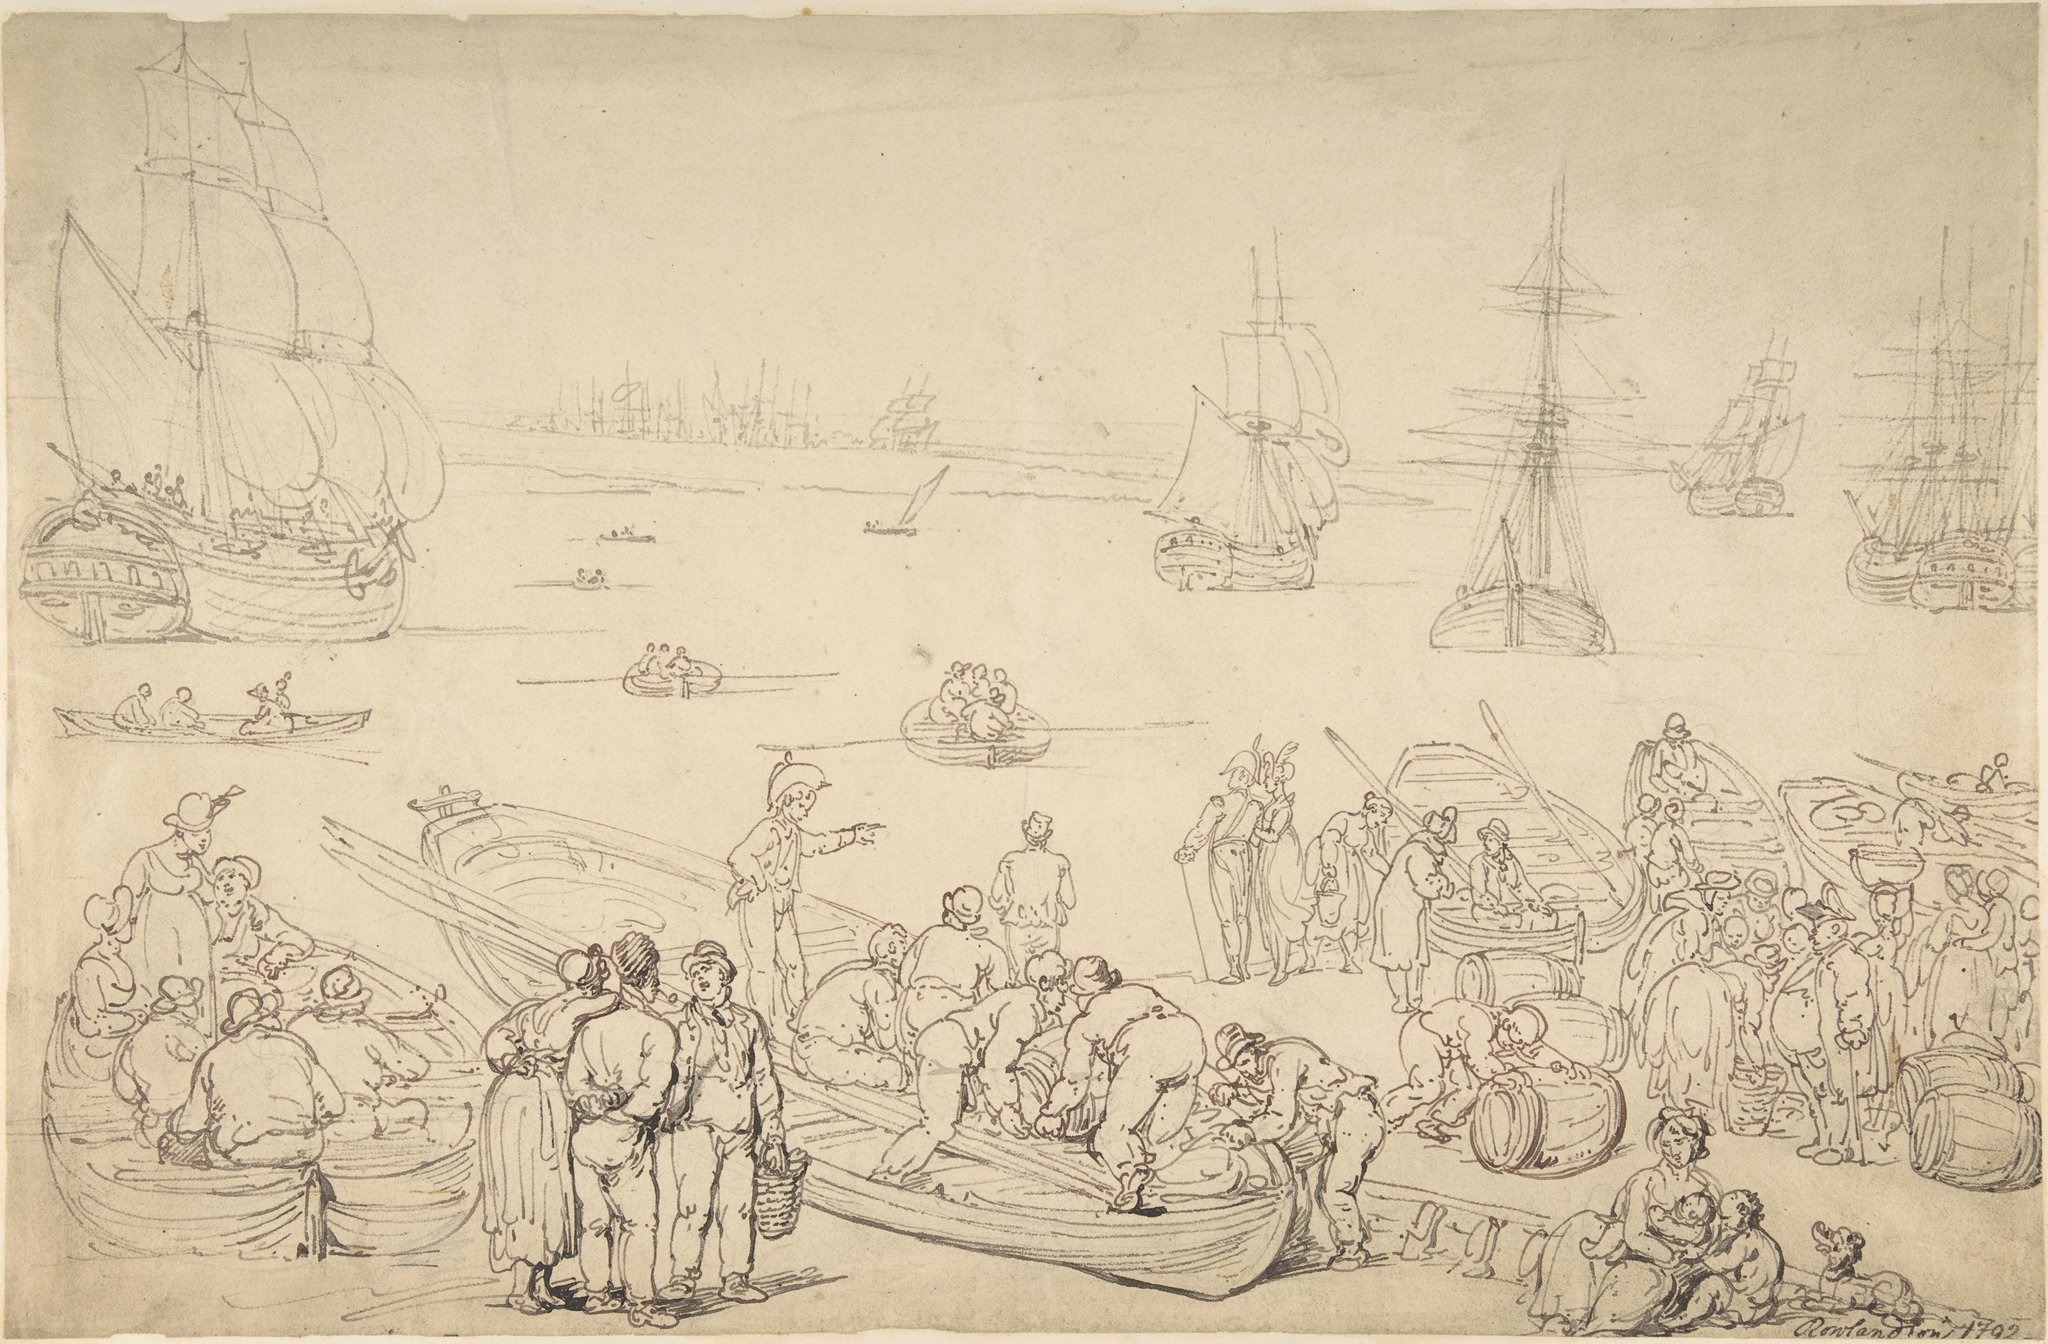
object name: drawing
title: Seaport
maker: thomas rowlandson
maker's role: artist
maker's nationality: british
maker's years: 1757-1827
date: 1792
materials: ink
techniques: pen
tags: men,women,boats,ships